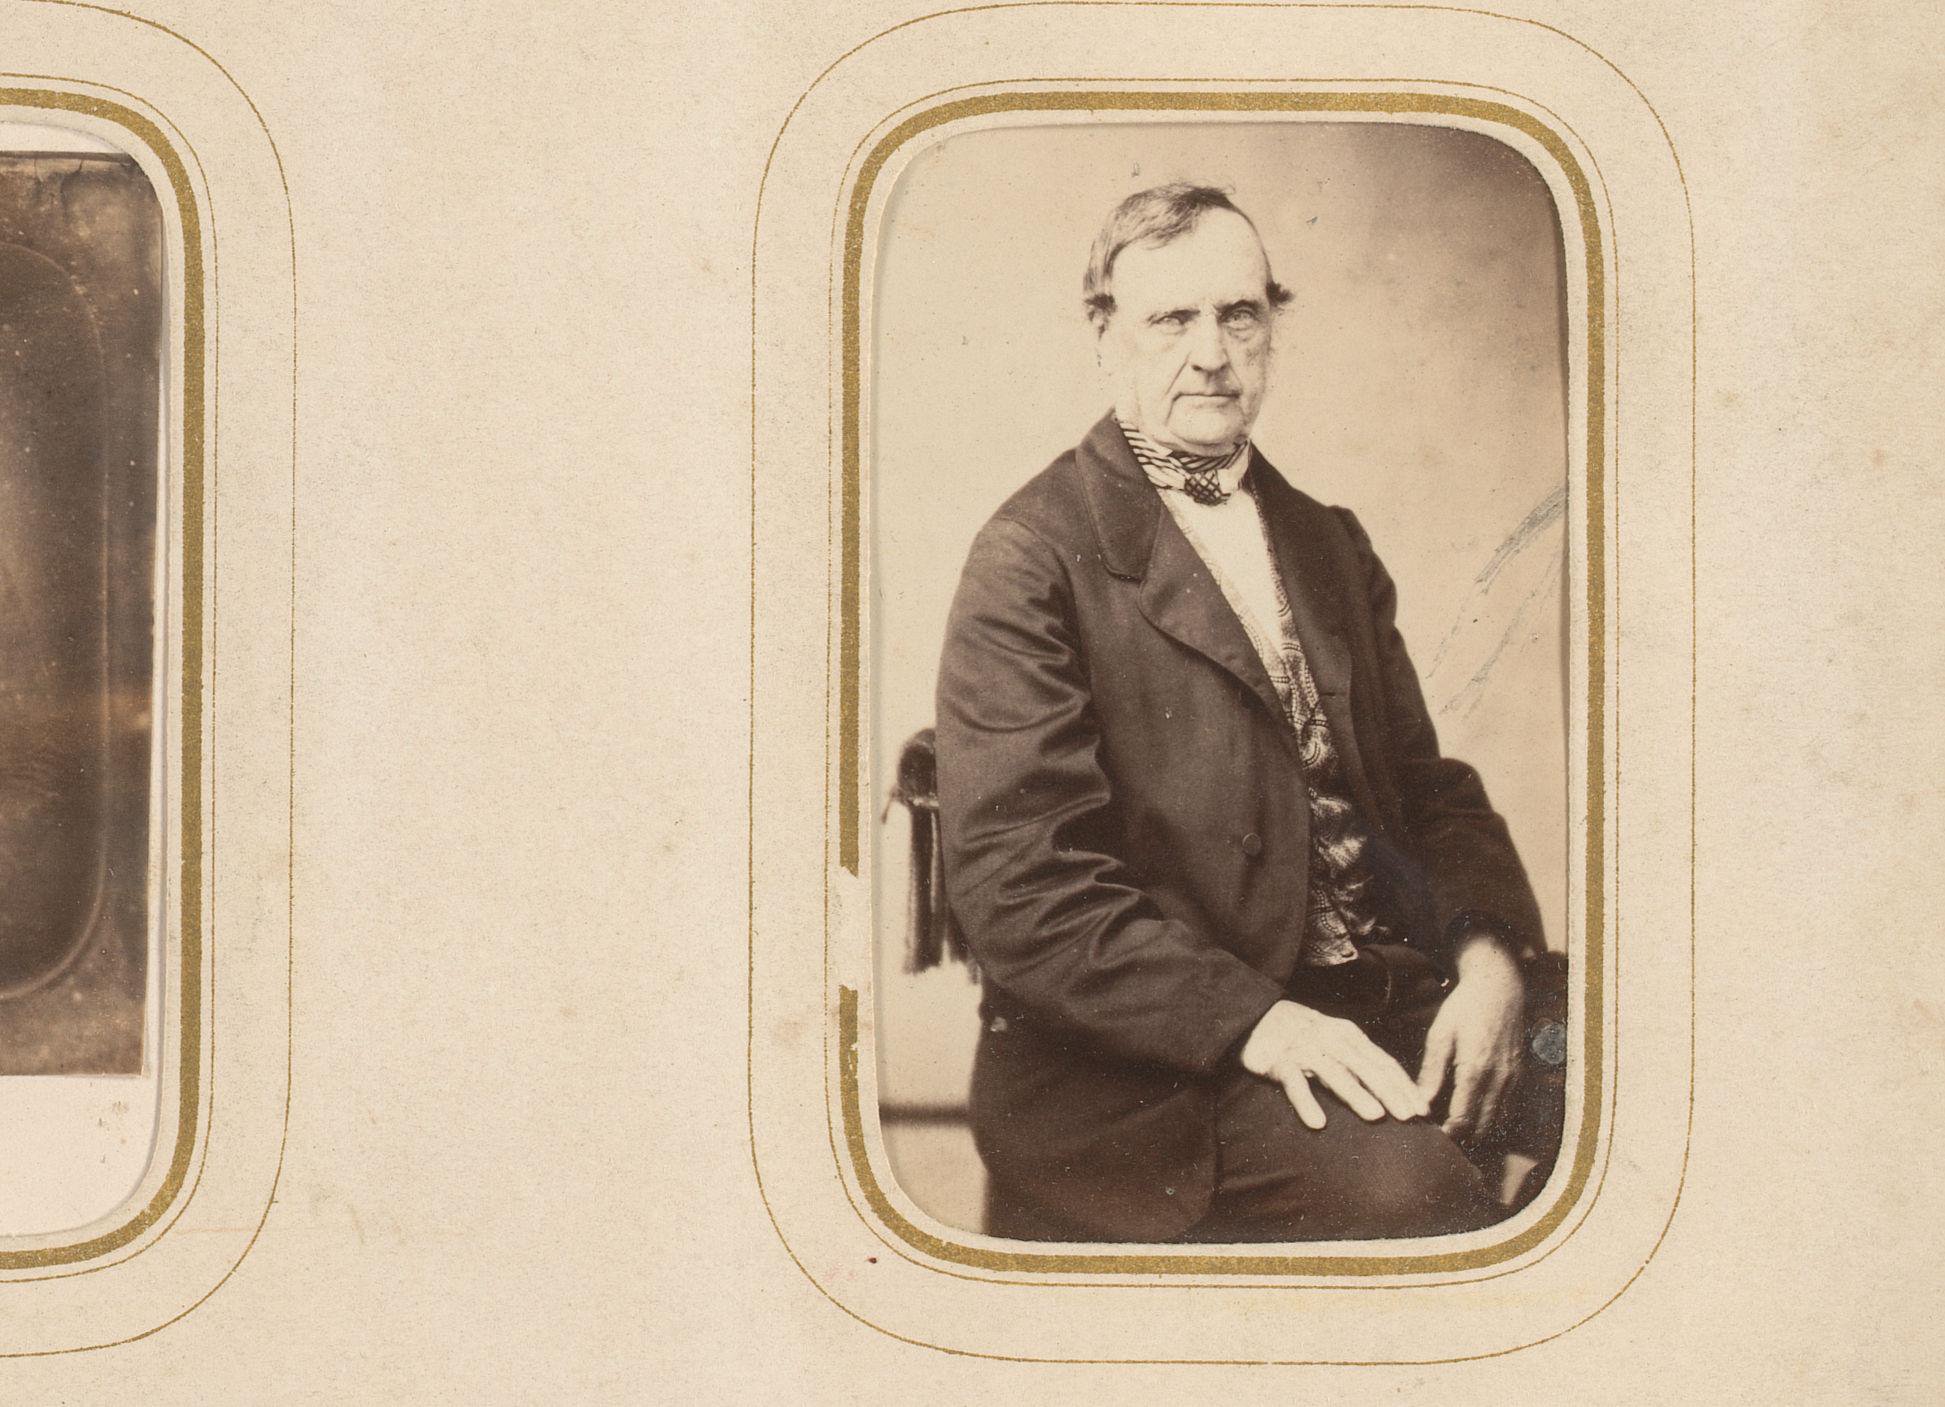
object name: album leaf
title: Portret van een zittende man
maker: Anonymous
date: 1860-1890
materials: cardboard, photographic support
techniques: albumen print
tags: historical persons